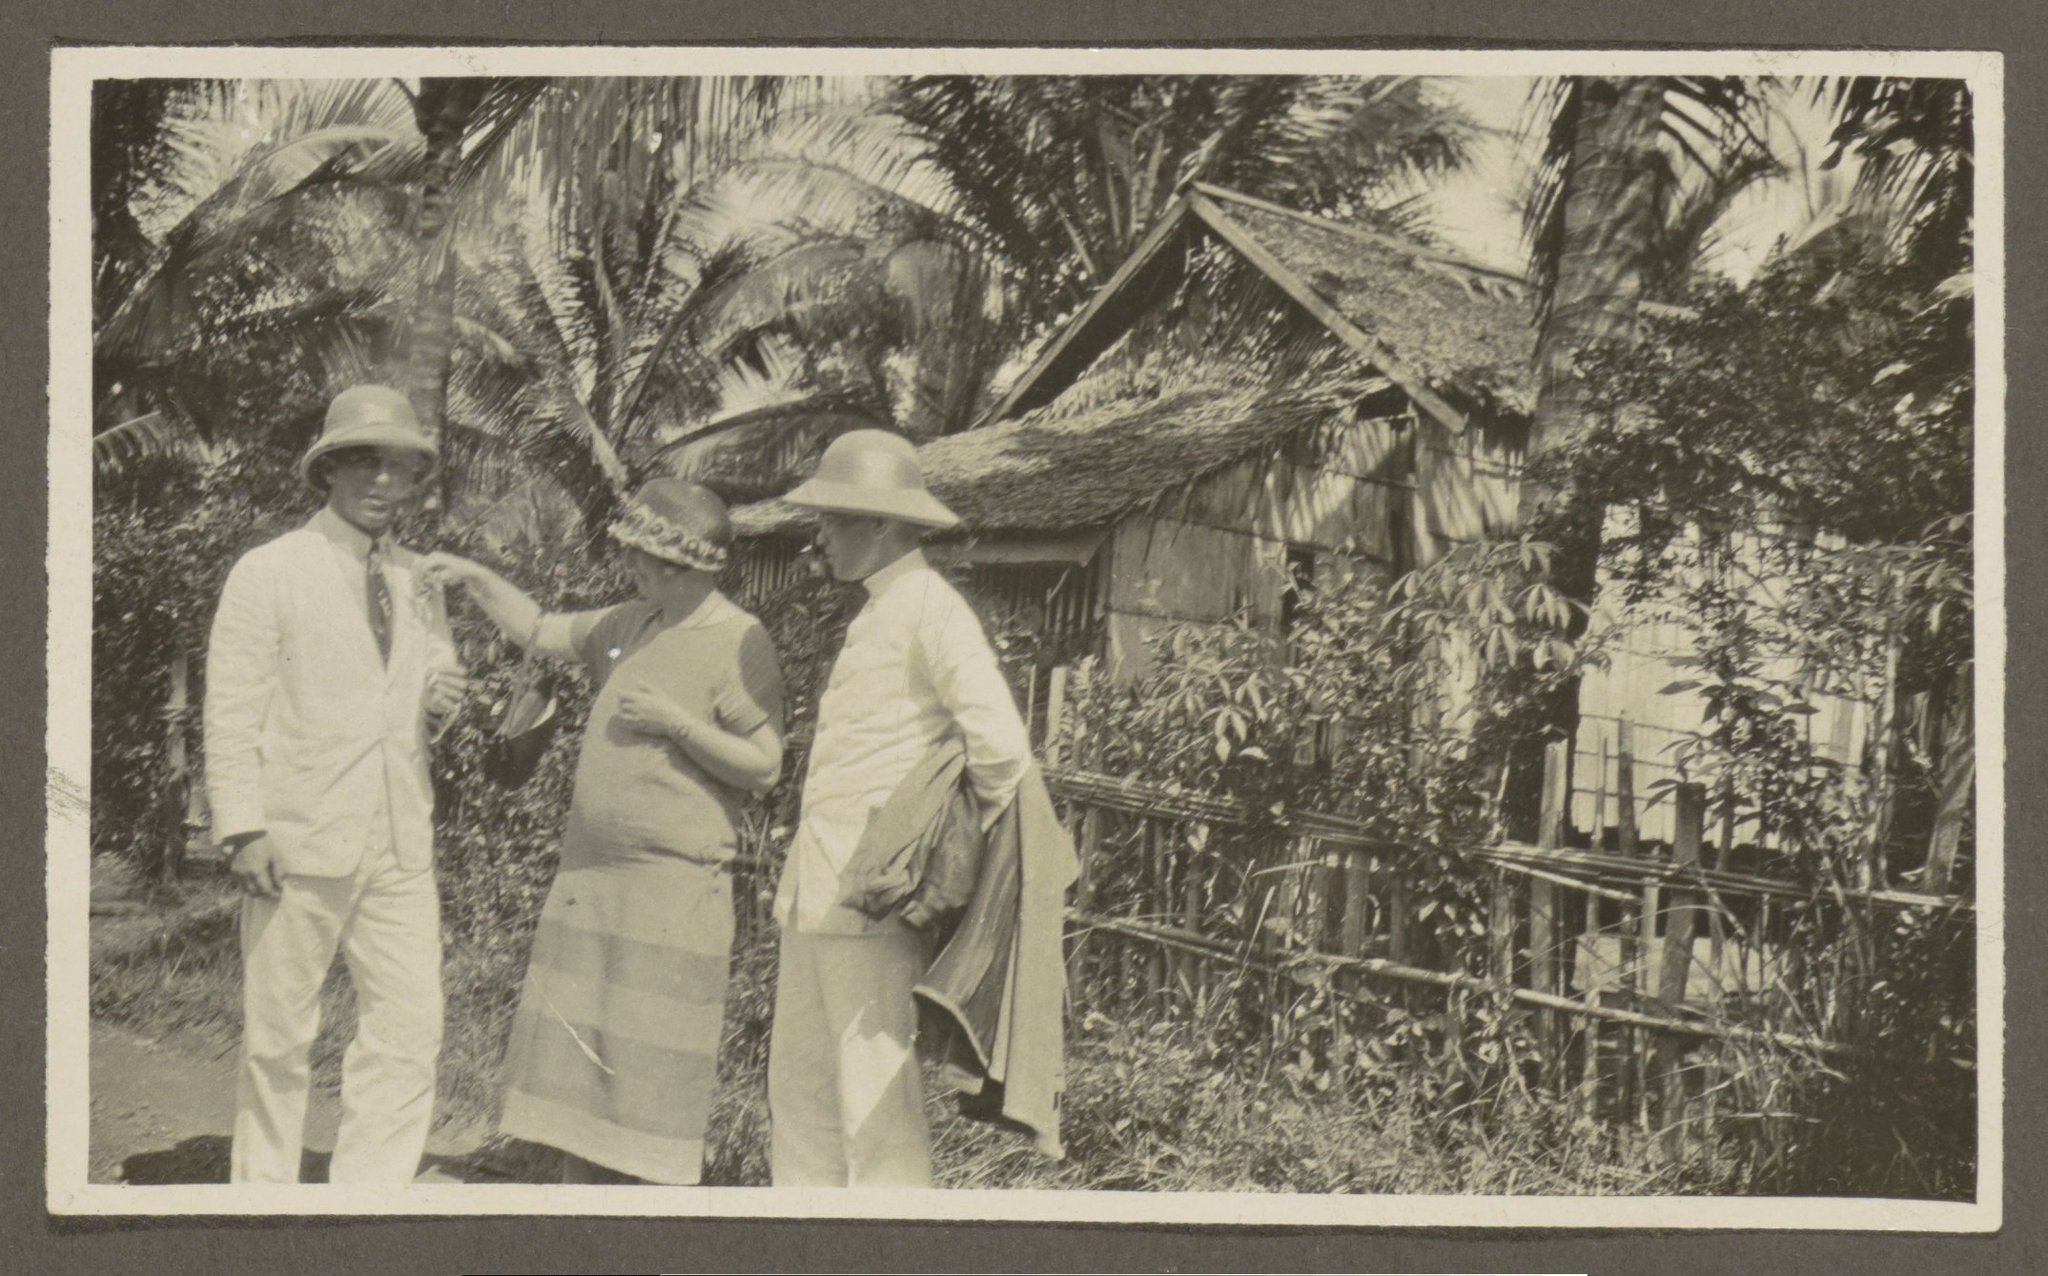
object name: photograph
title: Twee mannen in tropenkleding en een vrouw bij een hut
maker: Anonymous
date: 1920-1930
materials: photographic support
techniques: gelatin silver print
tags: dutch east indies, the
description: Onderdeel van familiealbum Nederlands-Indië.